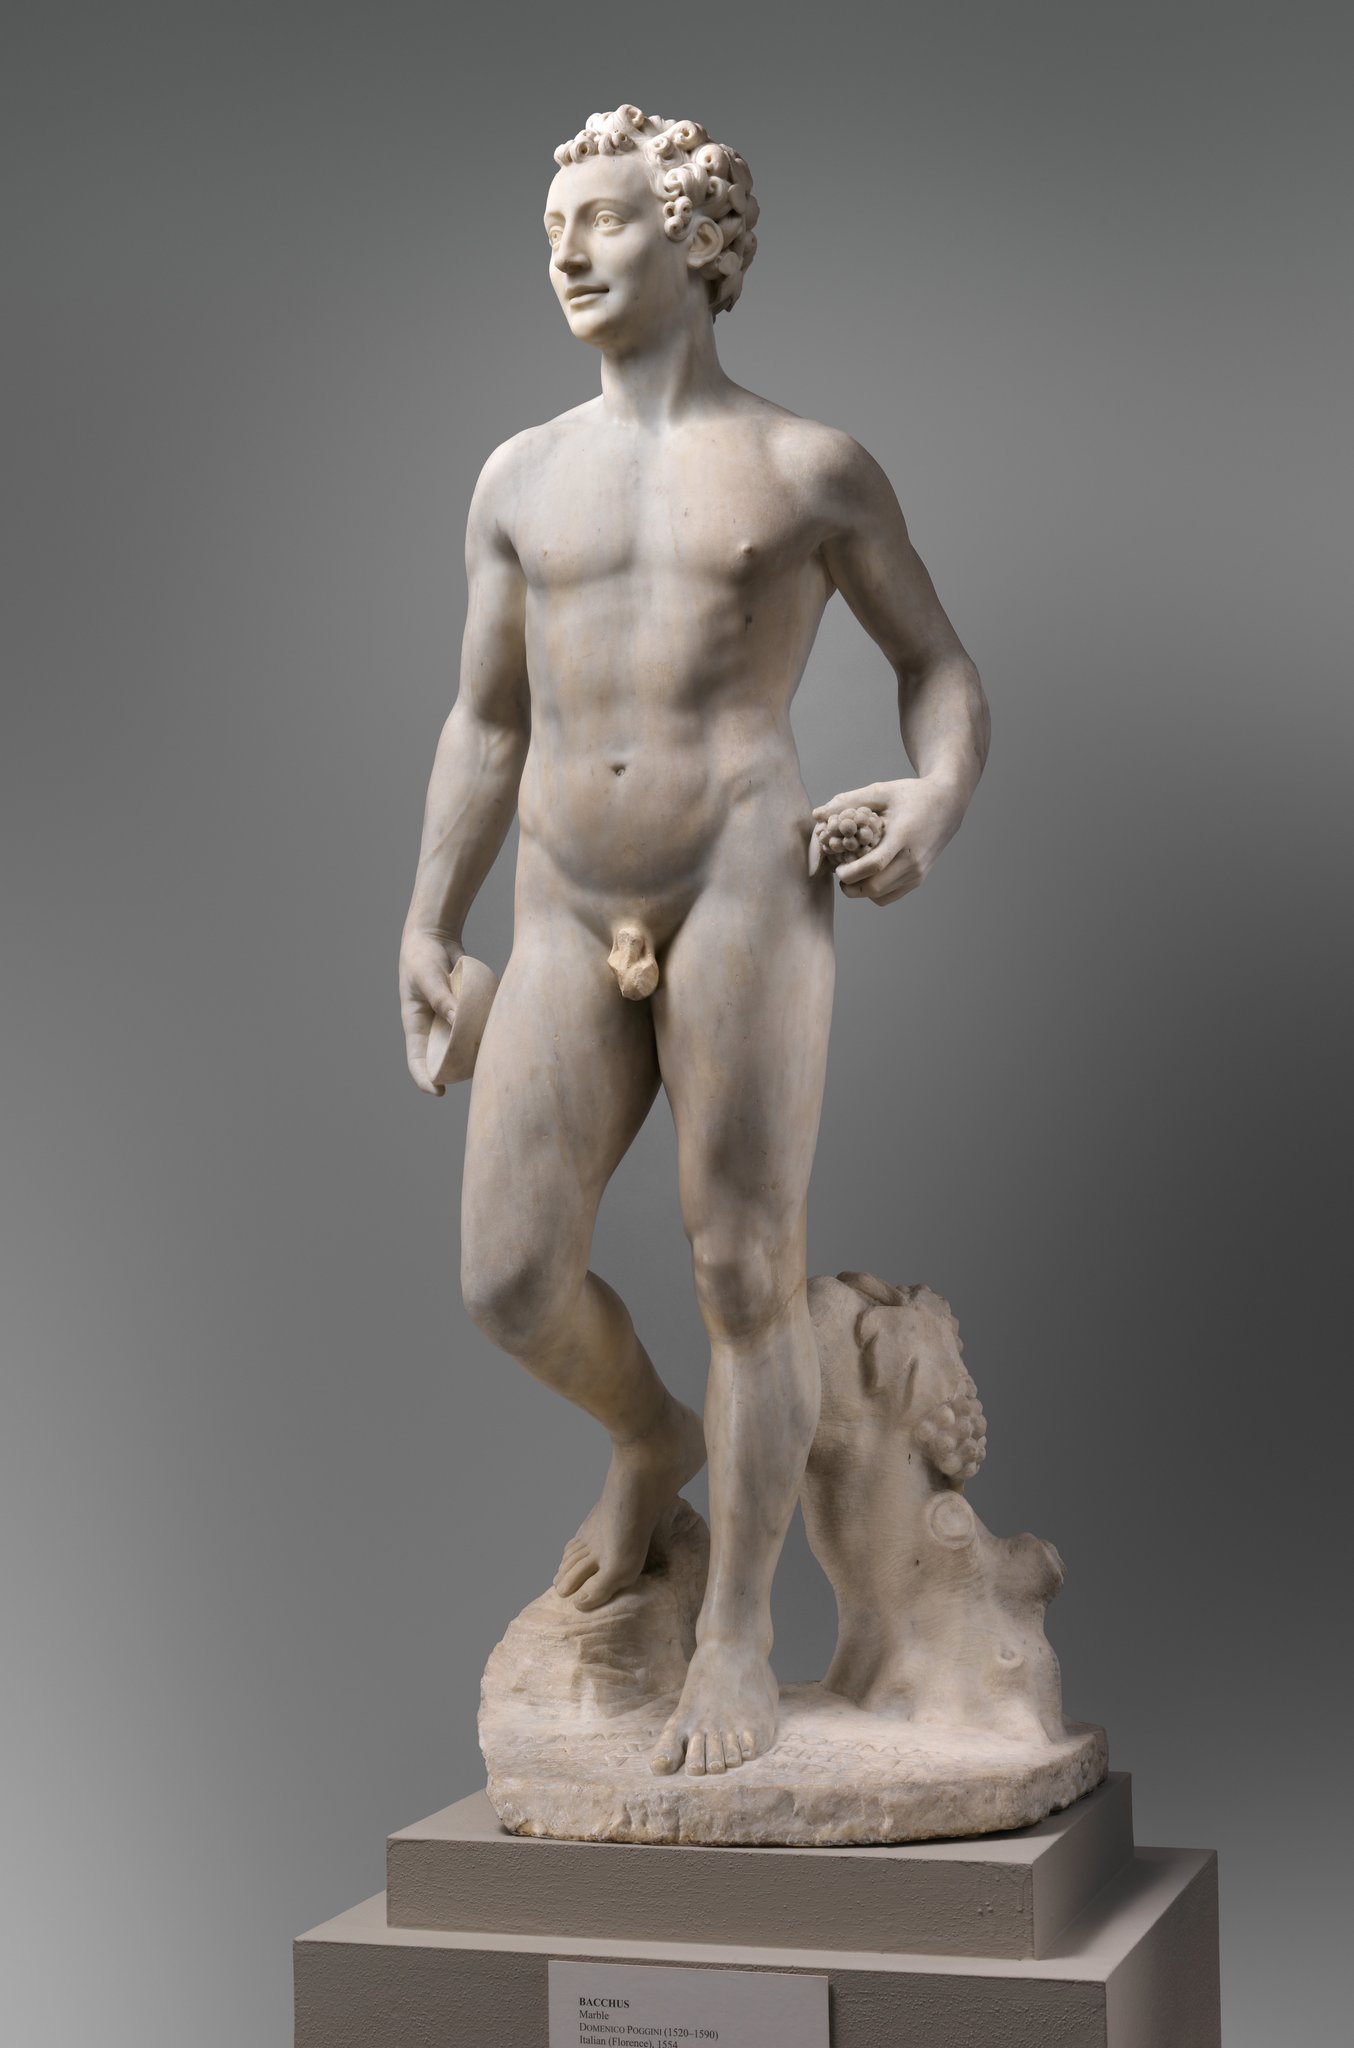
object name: statue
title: Bacchus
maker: domenico poggini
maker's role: artist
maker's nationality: italian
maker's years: 1520-1590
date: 1554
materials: marble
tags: bacchus